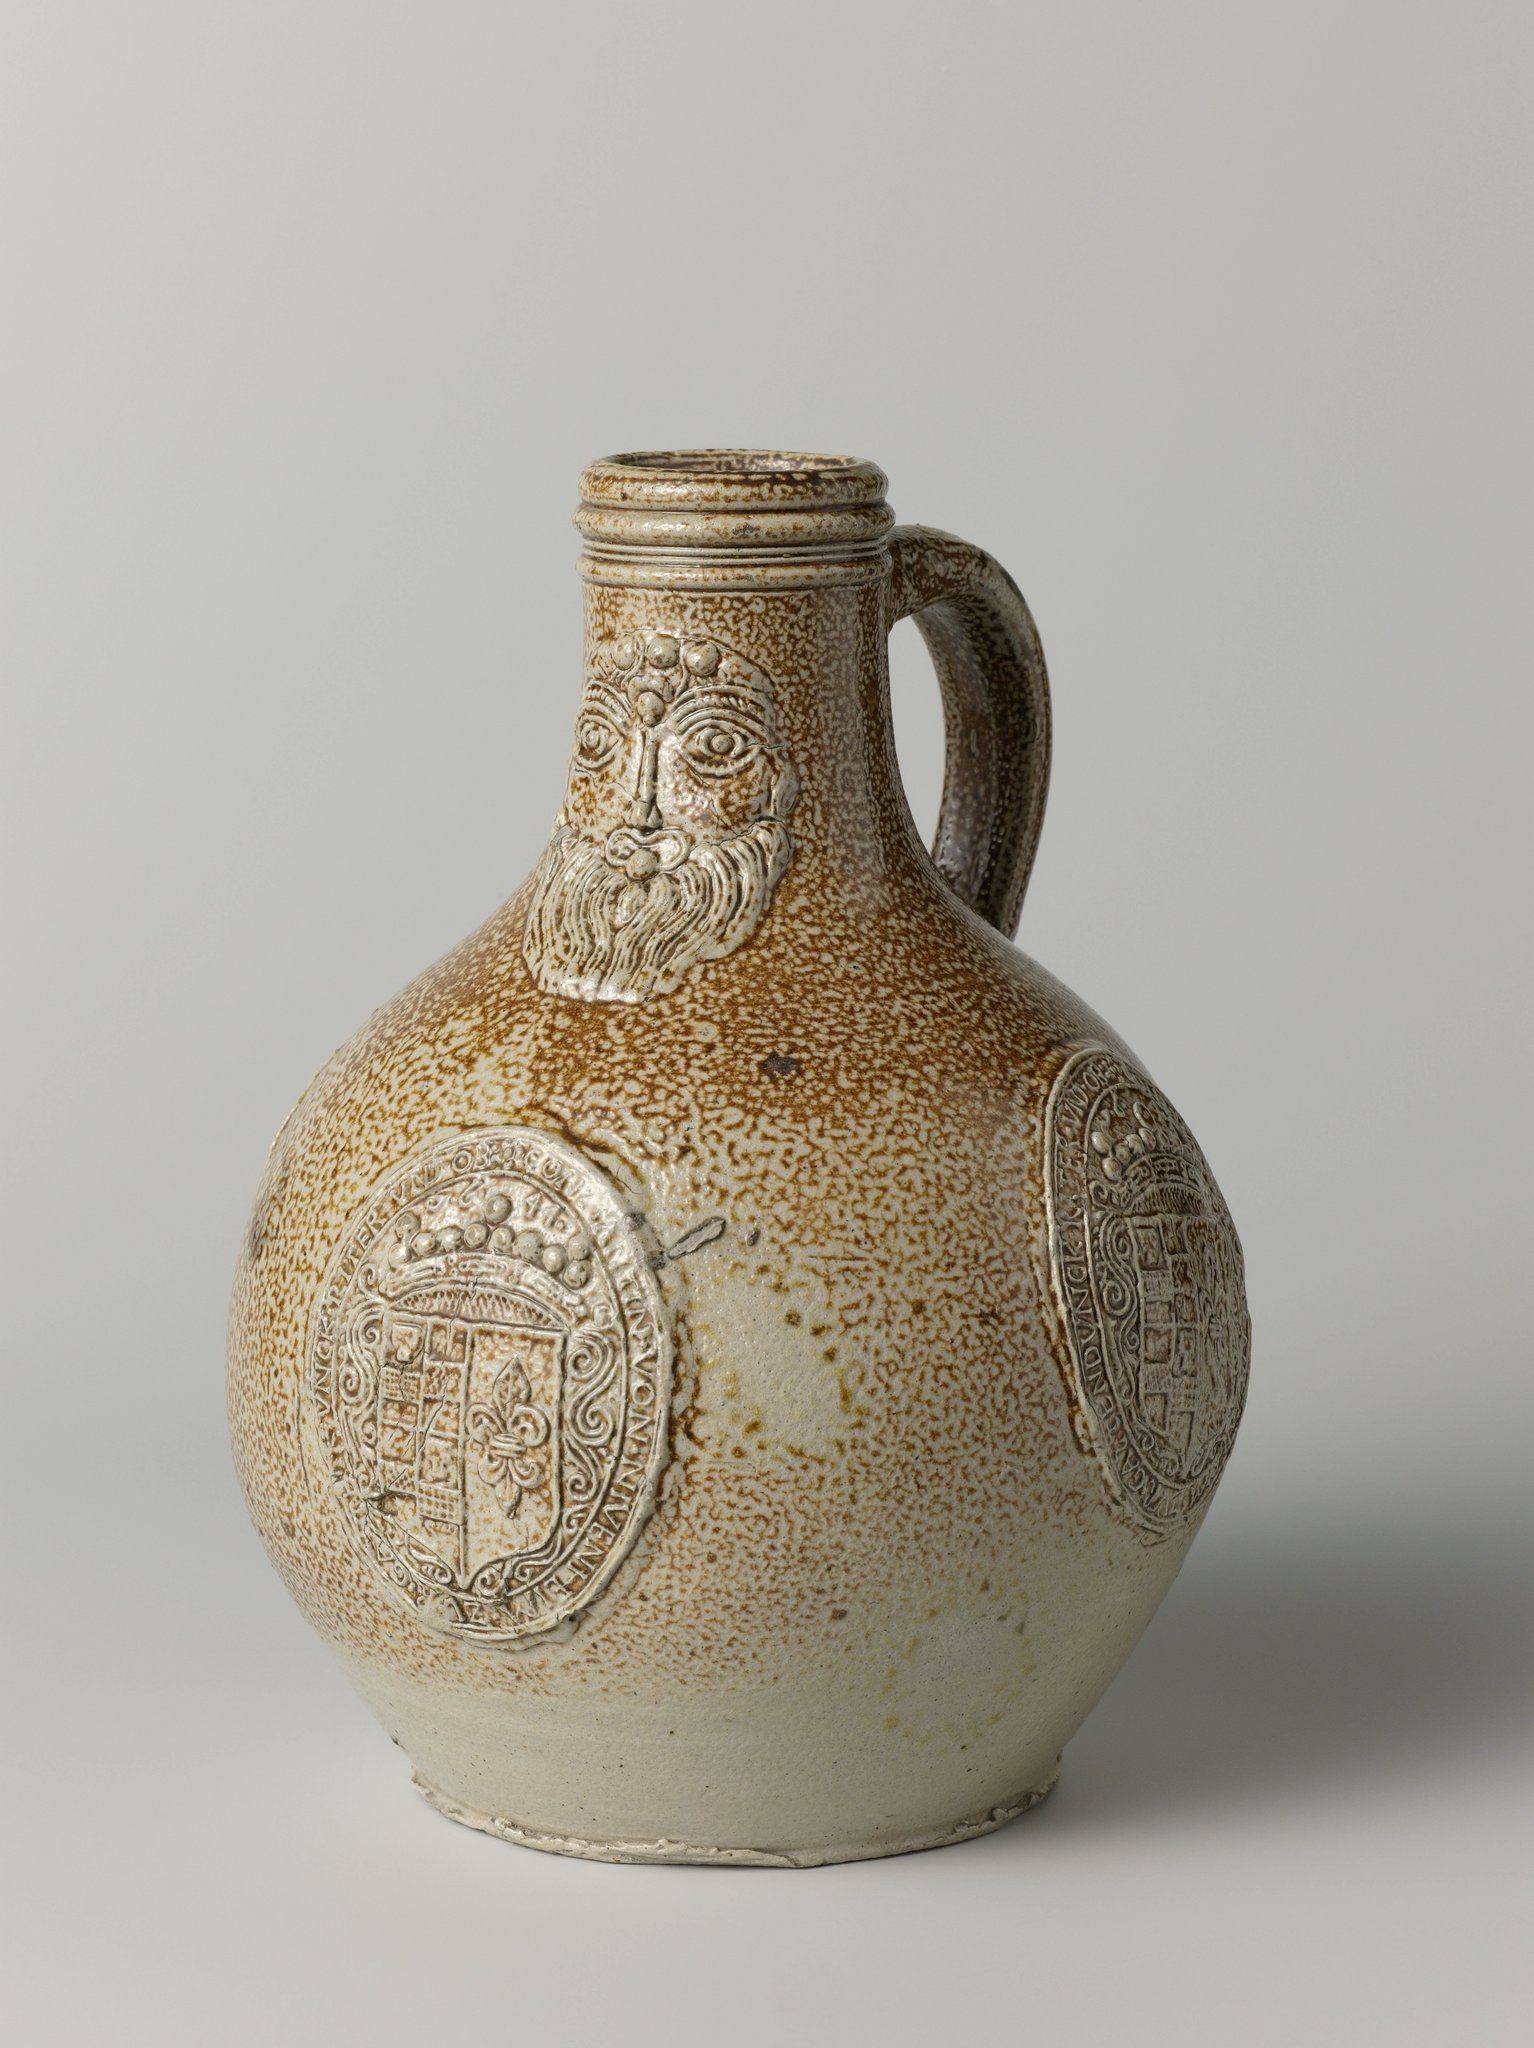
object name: jug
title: Bartmann (bearded-man) jug with the arms of Constantin von Nivenheim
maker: Anonymous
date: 1644-1660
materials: engobe, glaze, stoneware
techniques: firing, forming, relief, turning, vitrification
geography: frechen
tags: beard, armorial bearing, heraldry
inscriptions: date: ‘1644’, inscription: ‘CONSTANTIN VON NIVENHEIM ZVR GASTENDVNCK RITER UND OB’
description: Kruik (baardmankruik) van steengoed op standvlak met een bolvormig lichaam en smalle nek. Het C-vormige oor is bevestigd aan de nek en de schouder. Profielen op de nek. Bedekt met een bruine engobe. Op de buik in reliëf driemaal een gedrukt en opgelegd en opgelegd medaillon met een gekroond wapen en het opschrift 'CONSTANTIN VON NIVENHEIM ZVR GASTENDVNCK RITER UND OB' en de datum '1644'. Op de nek, doorlopend op de schouder, een baardman. Frechen.